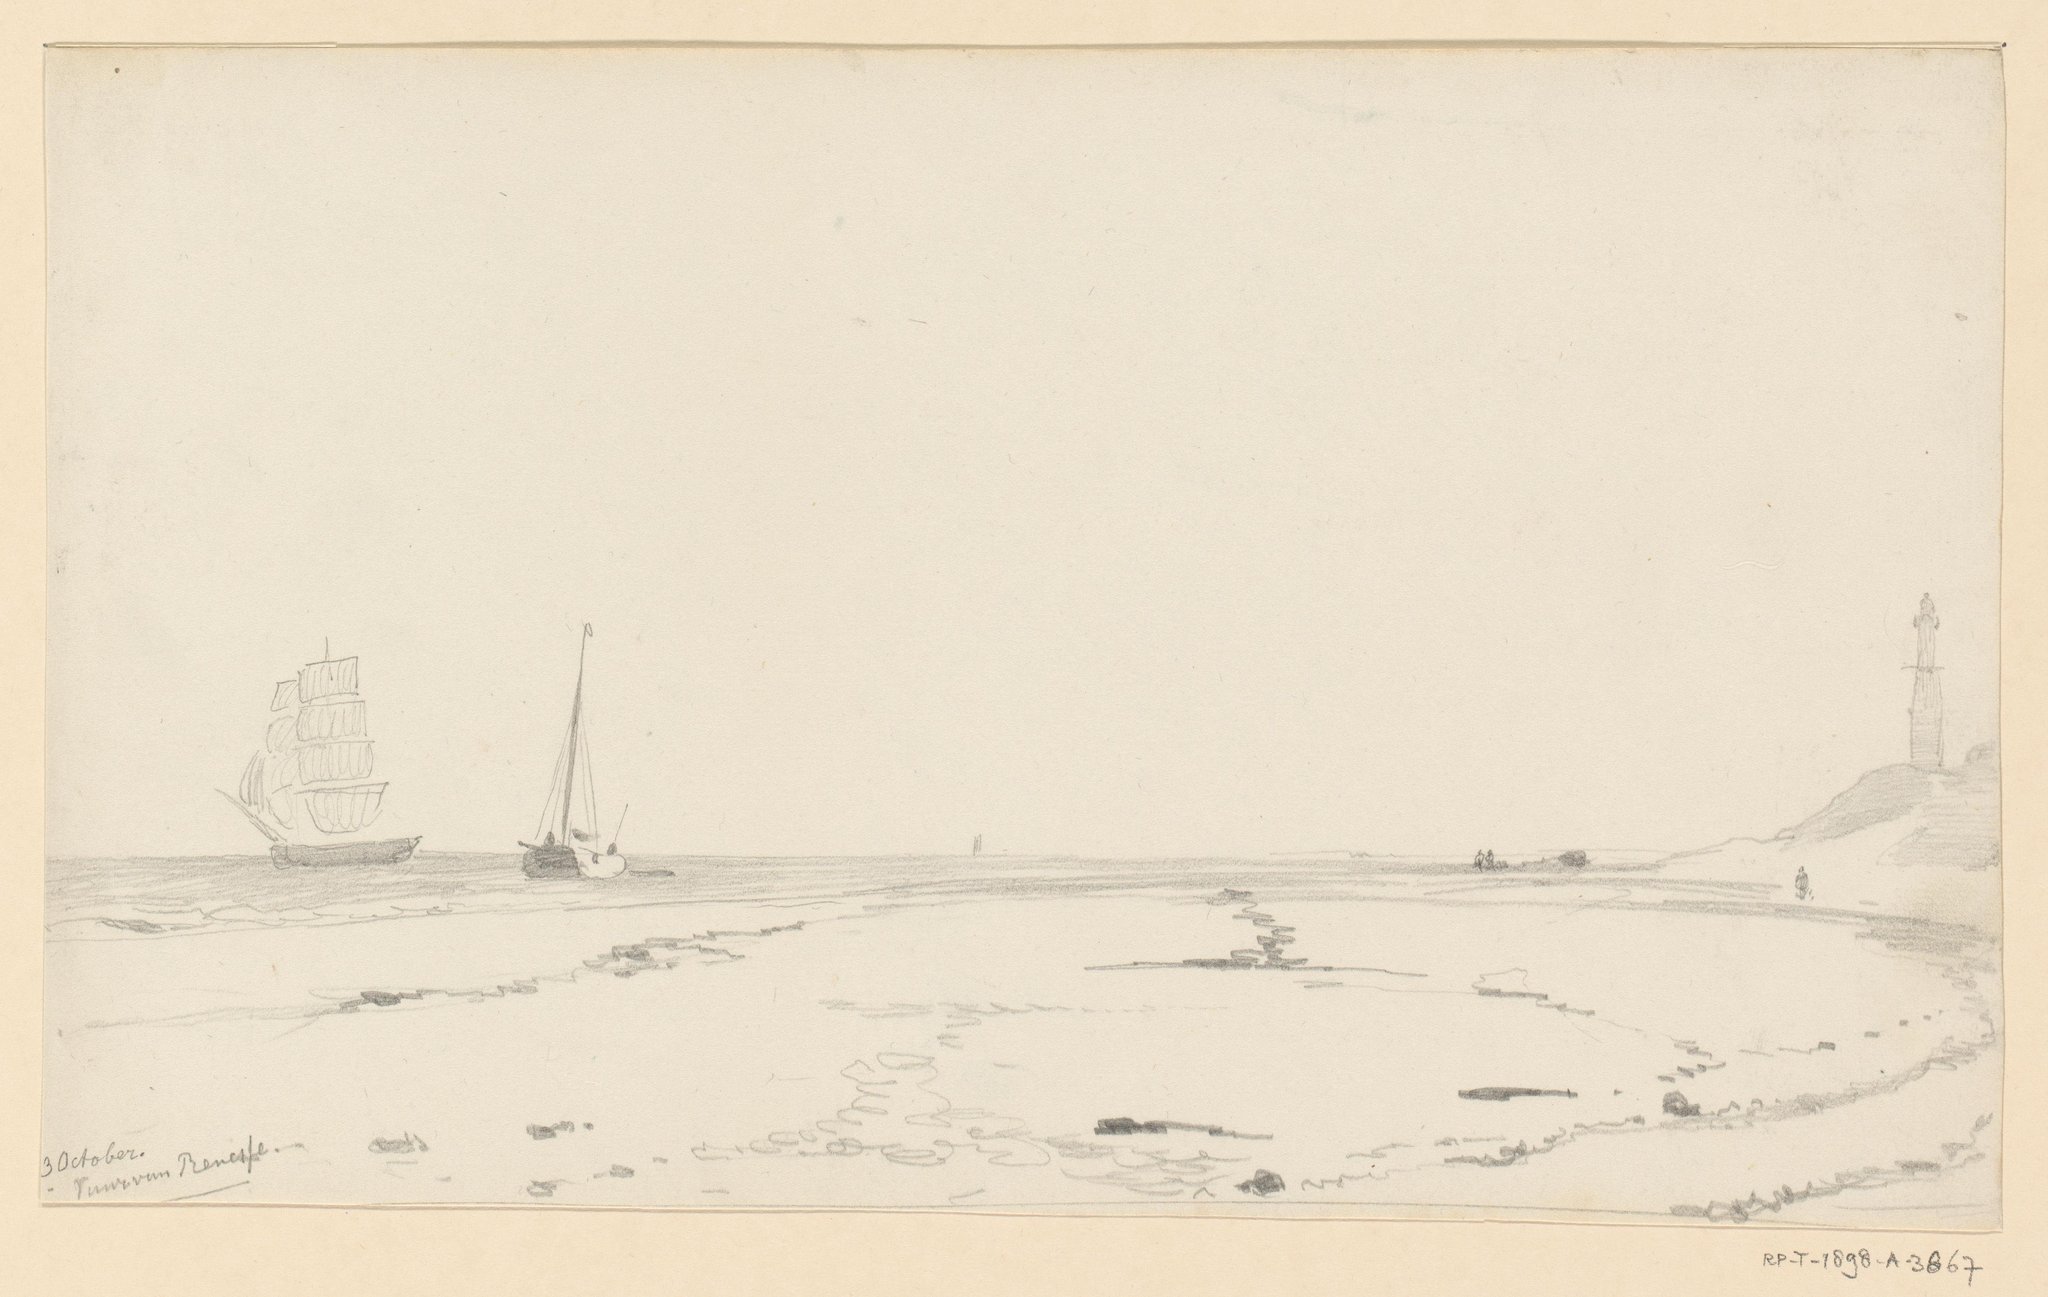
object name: drawing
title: Kust bij Renesse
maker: willem anthonie van deventer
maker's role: draughtsman, painter, print maker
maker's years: 1824-1893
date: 1834-1893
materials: paper, pencil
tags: signalling ~ navigation, beach